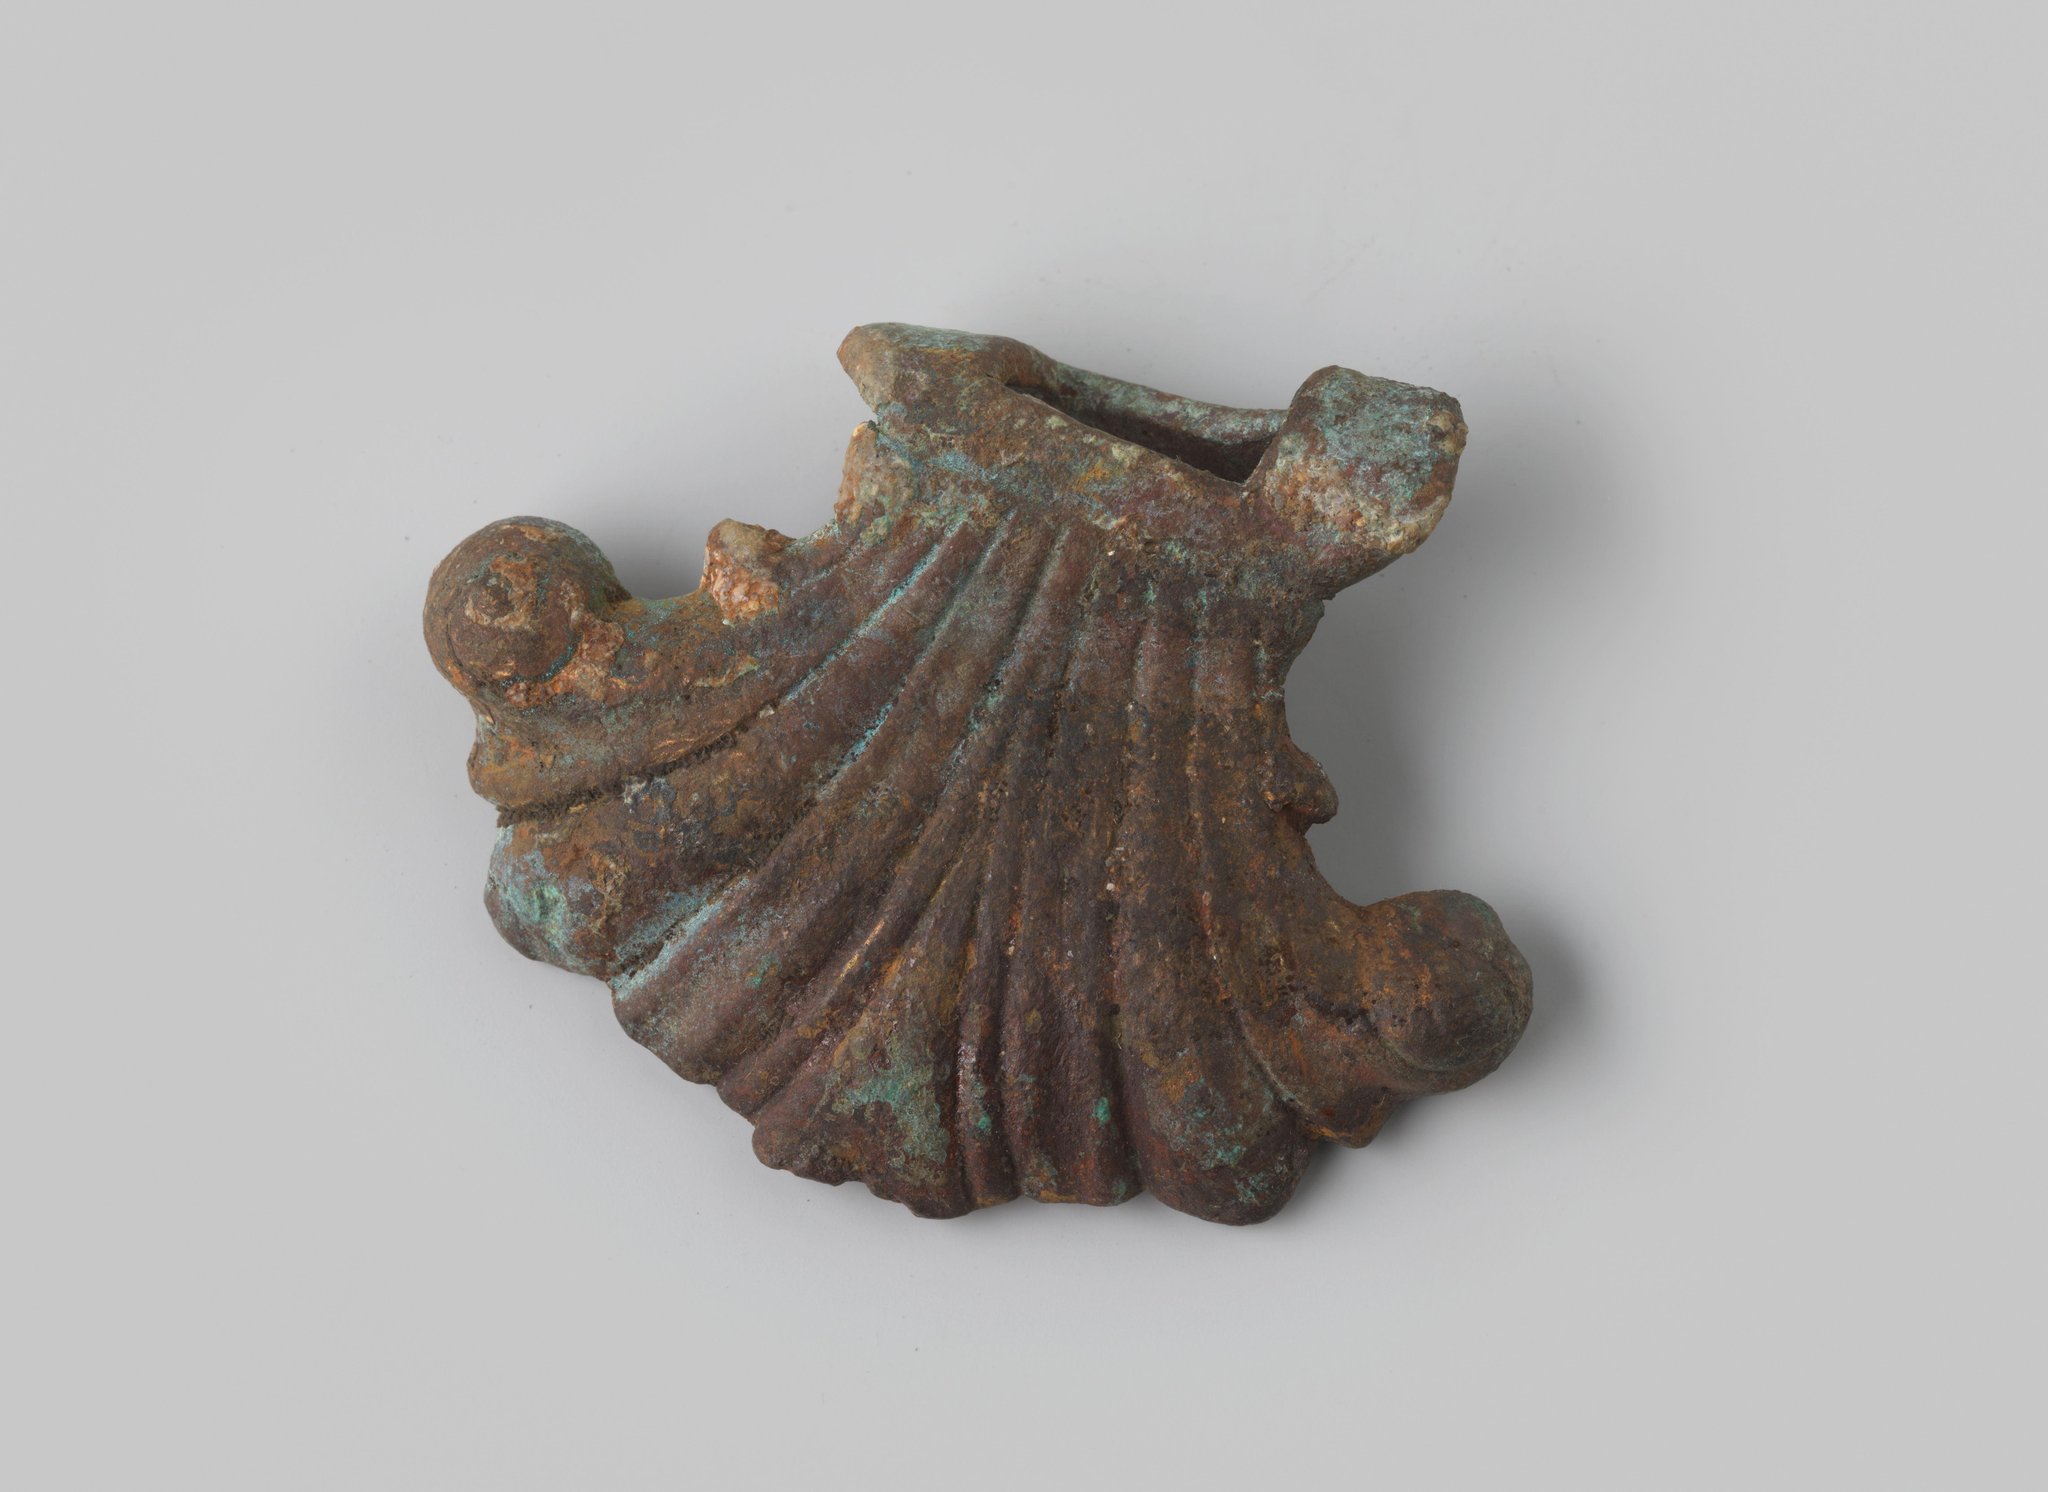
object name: beugel gevestl, gevestbeugel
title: Beugel van gevest uit het wrak van de Oost-Indiëvaarder Hollandia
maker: Anonymous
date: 1700-1743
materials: copper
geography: netherlands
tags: verenigde oostindische compagnie, hollandia (schip), annet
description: Hilt, guard; fragm, single shell, shell-shaped with scrolling wavy outlineand ribbed surface, rectangular hole at end bent.